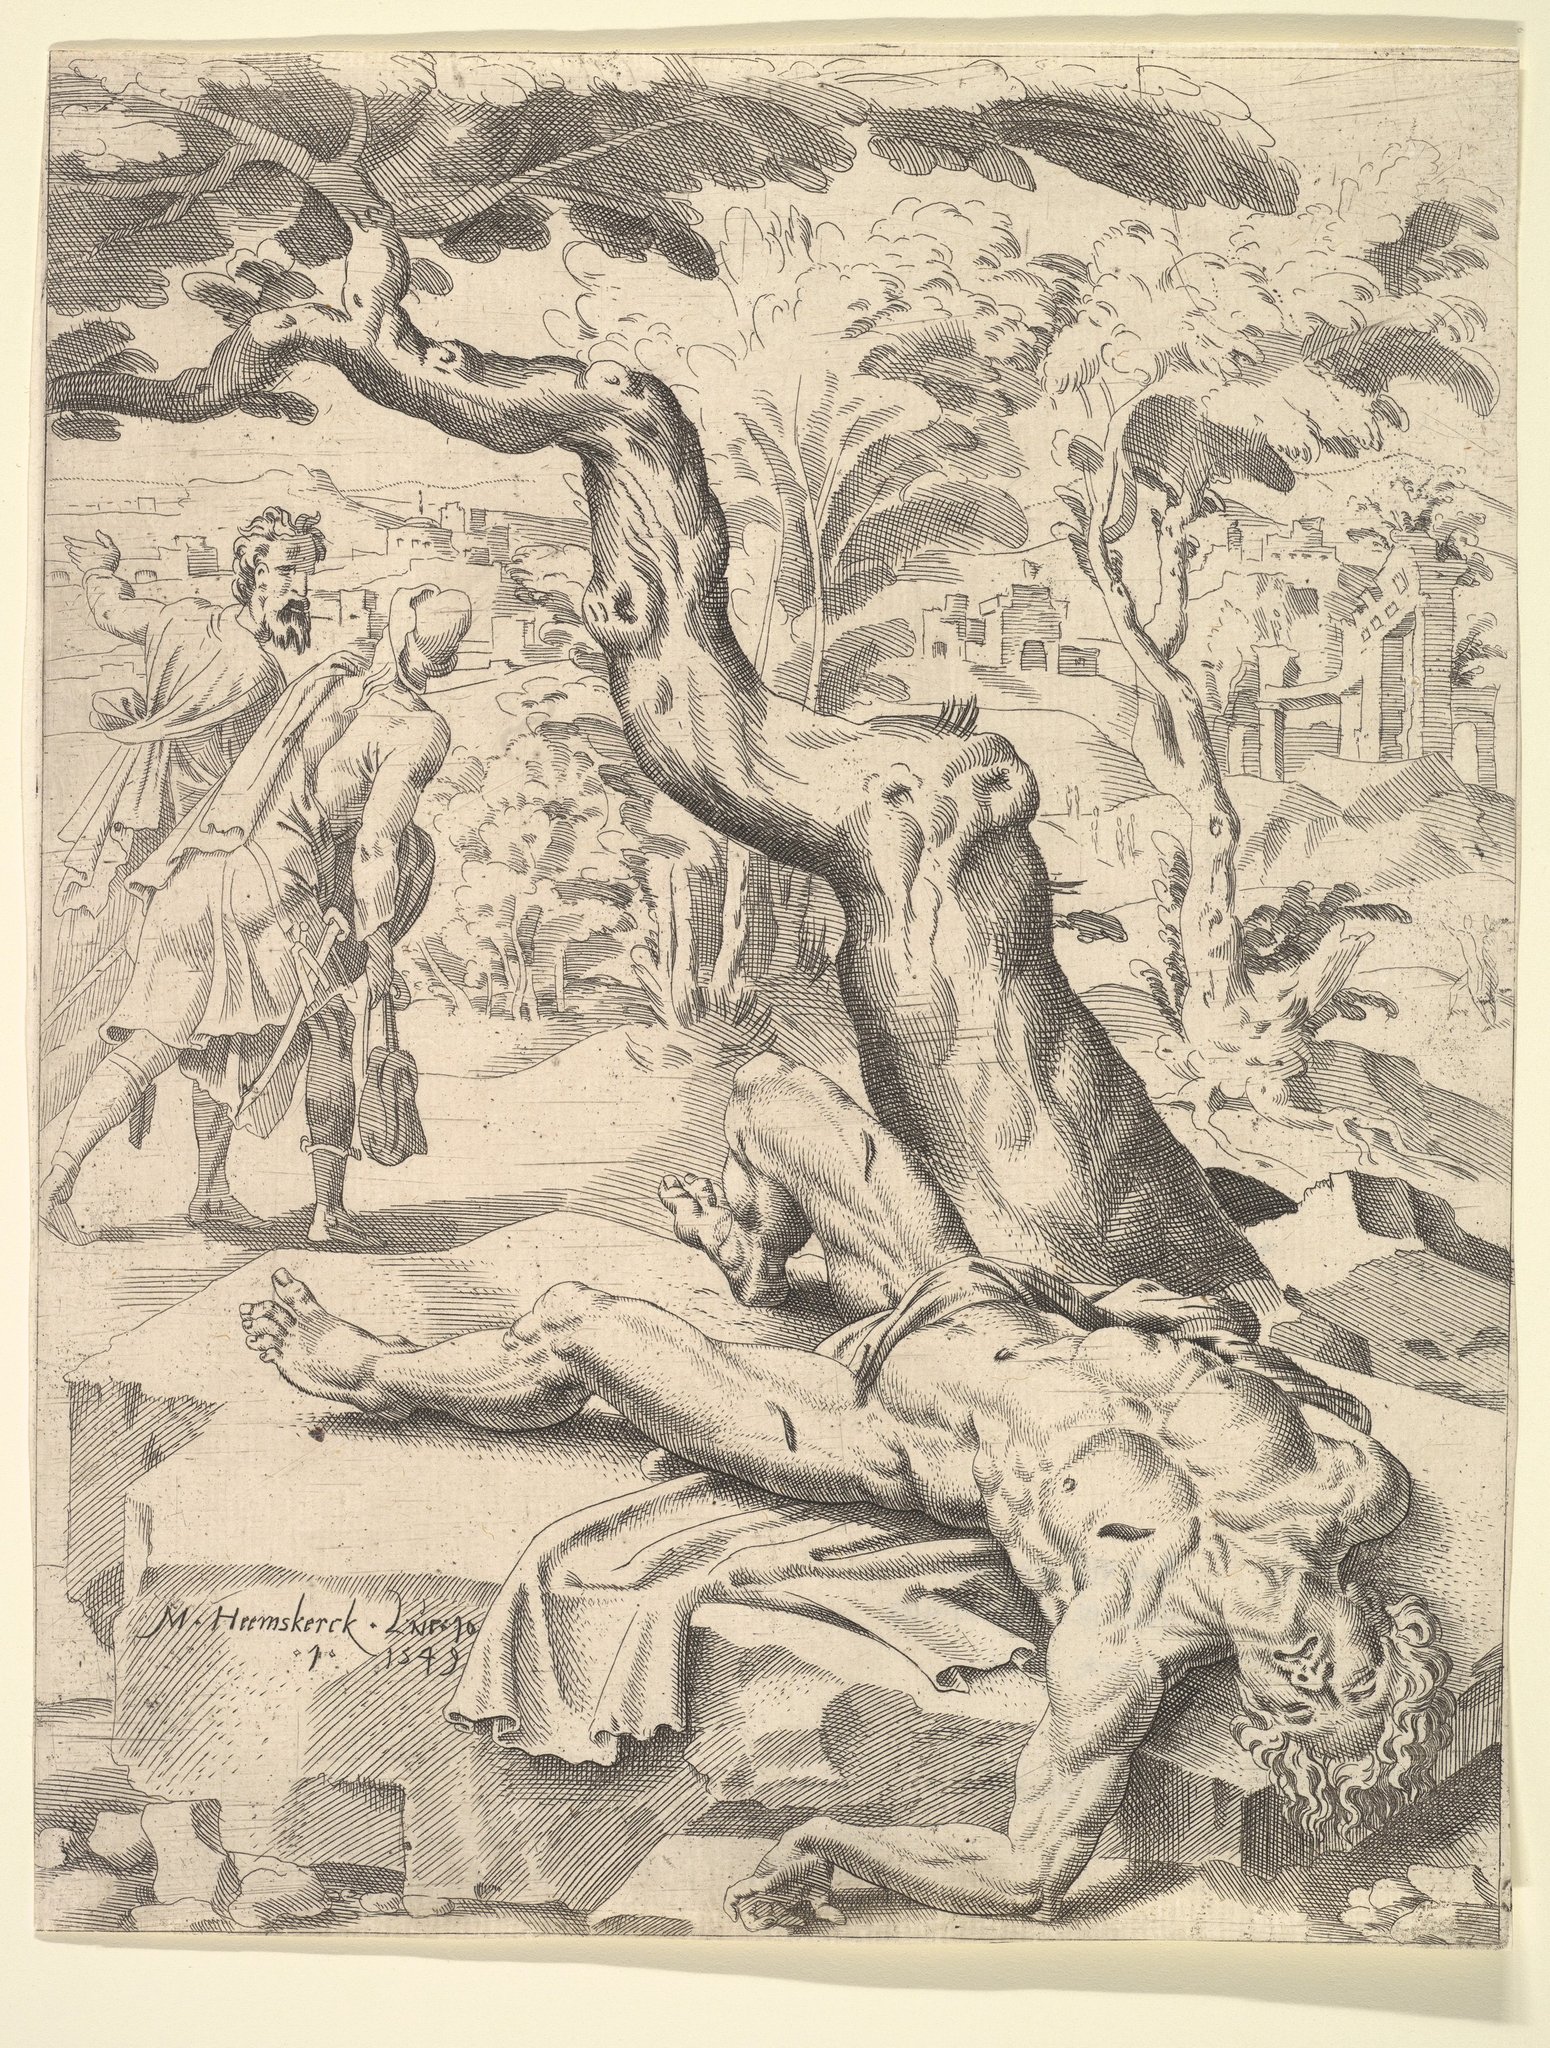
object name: print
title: The Parable of the Good Samaritan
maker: maarten van heemskerck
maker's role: artist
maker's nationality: netherlandish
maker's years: 1498-1574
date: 1549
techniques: etching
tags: men,trees